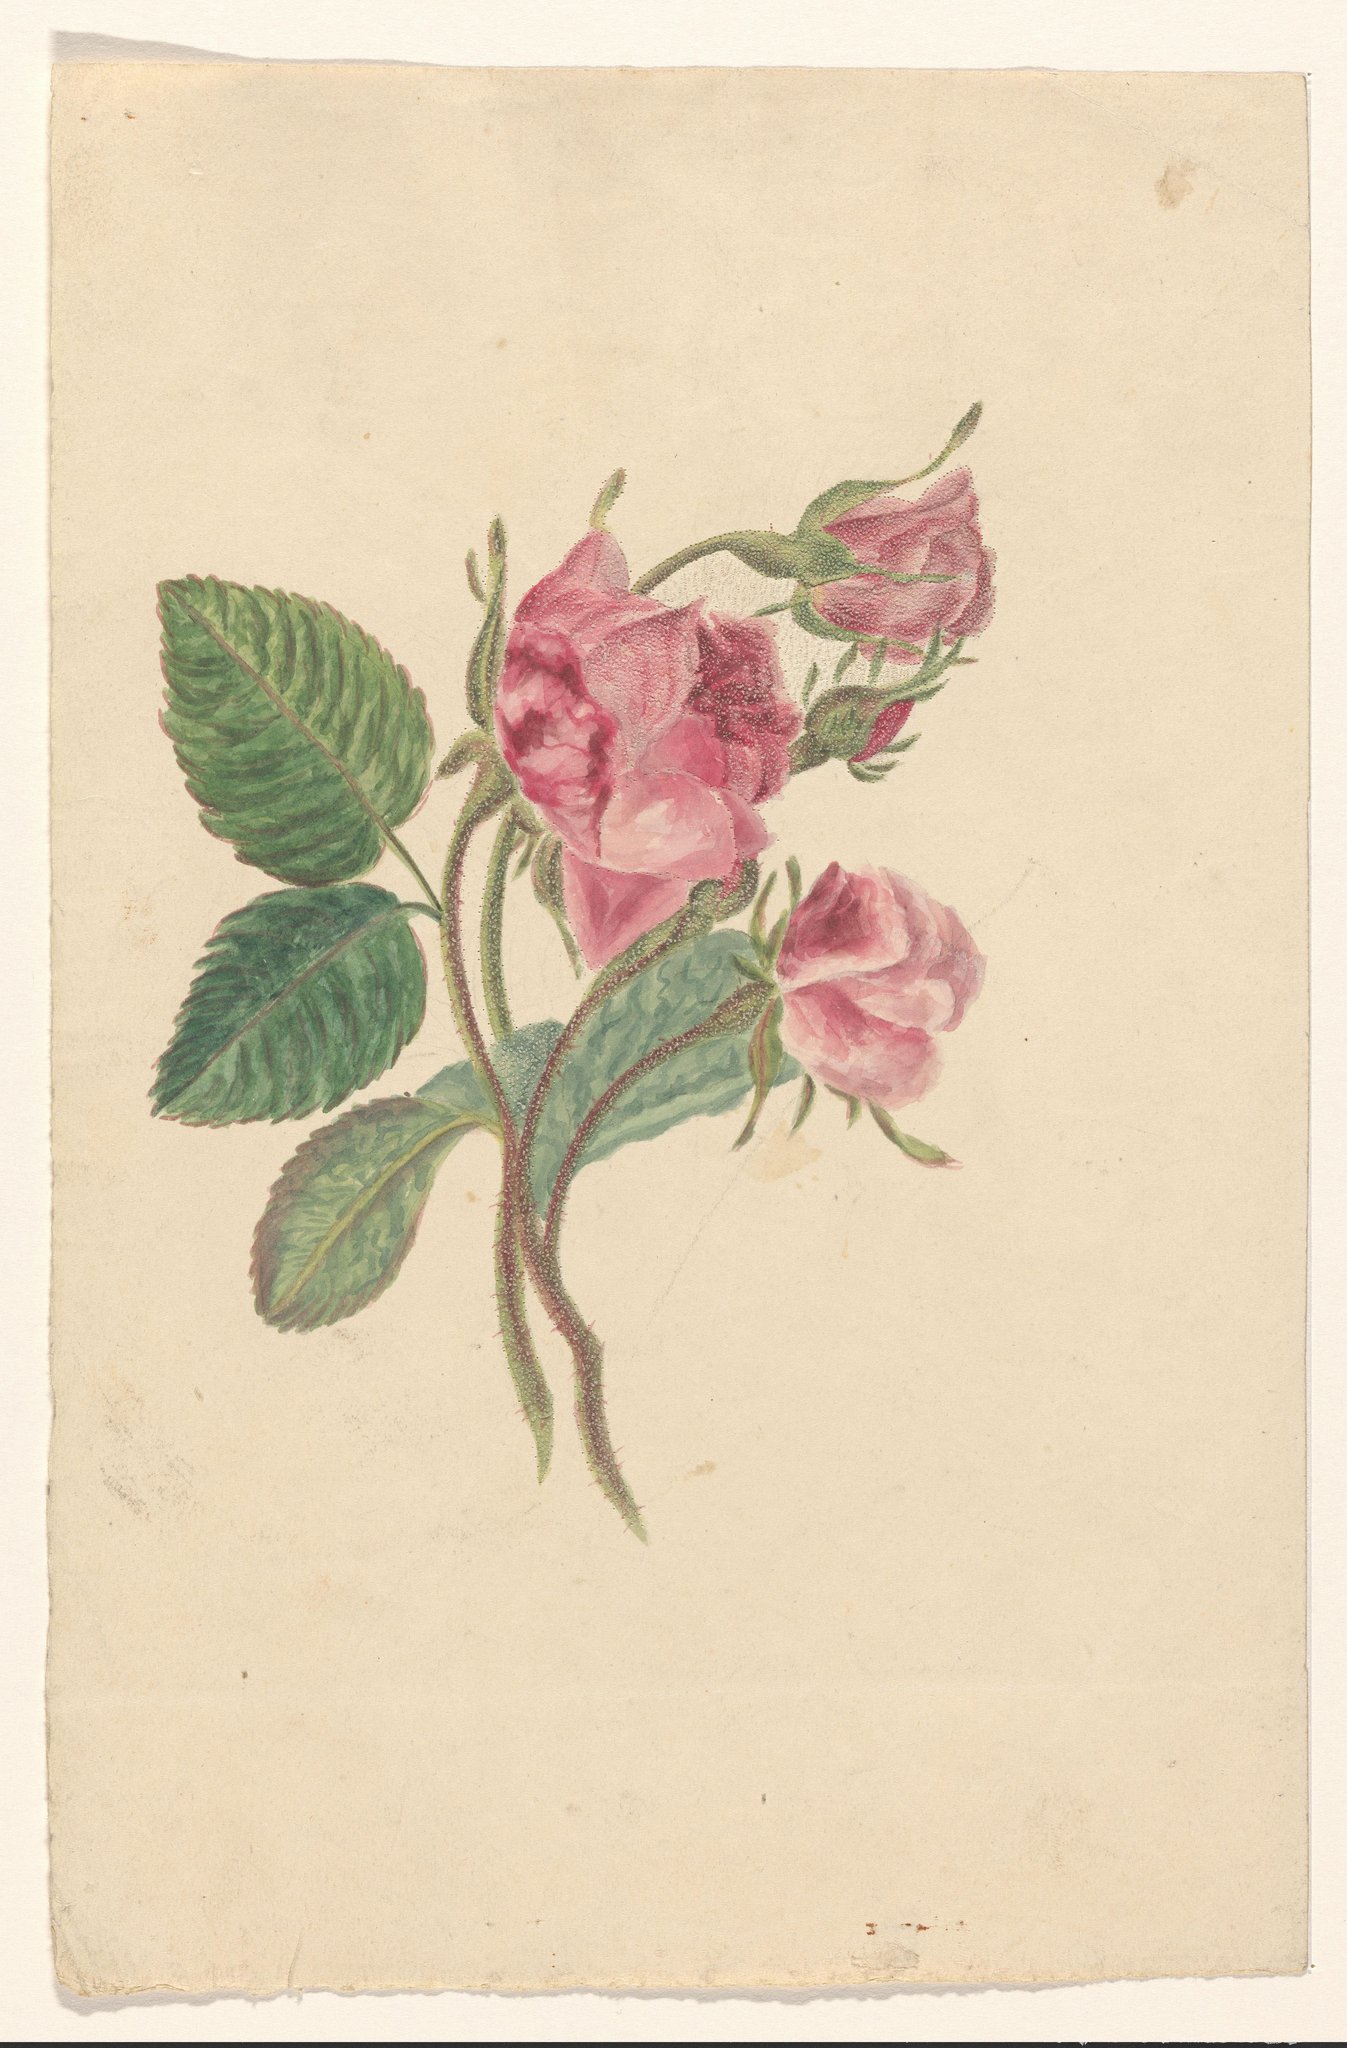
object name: drawing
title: Roos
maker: Anonymous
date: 1830-1890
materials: paper, pencil, watercolor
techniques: brush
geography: netherlands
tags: flowers: rose